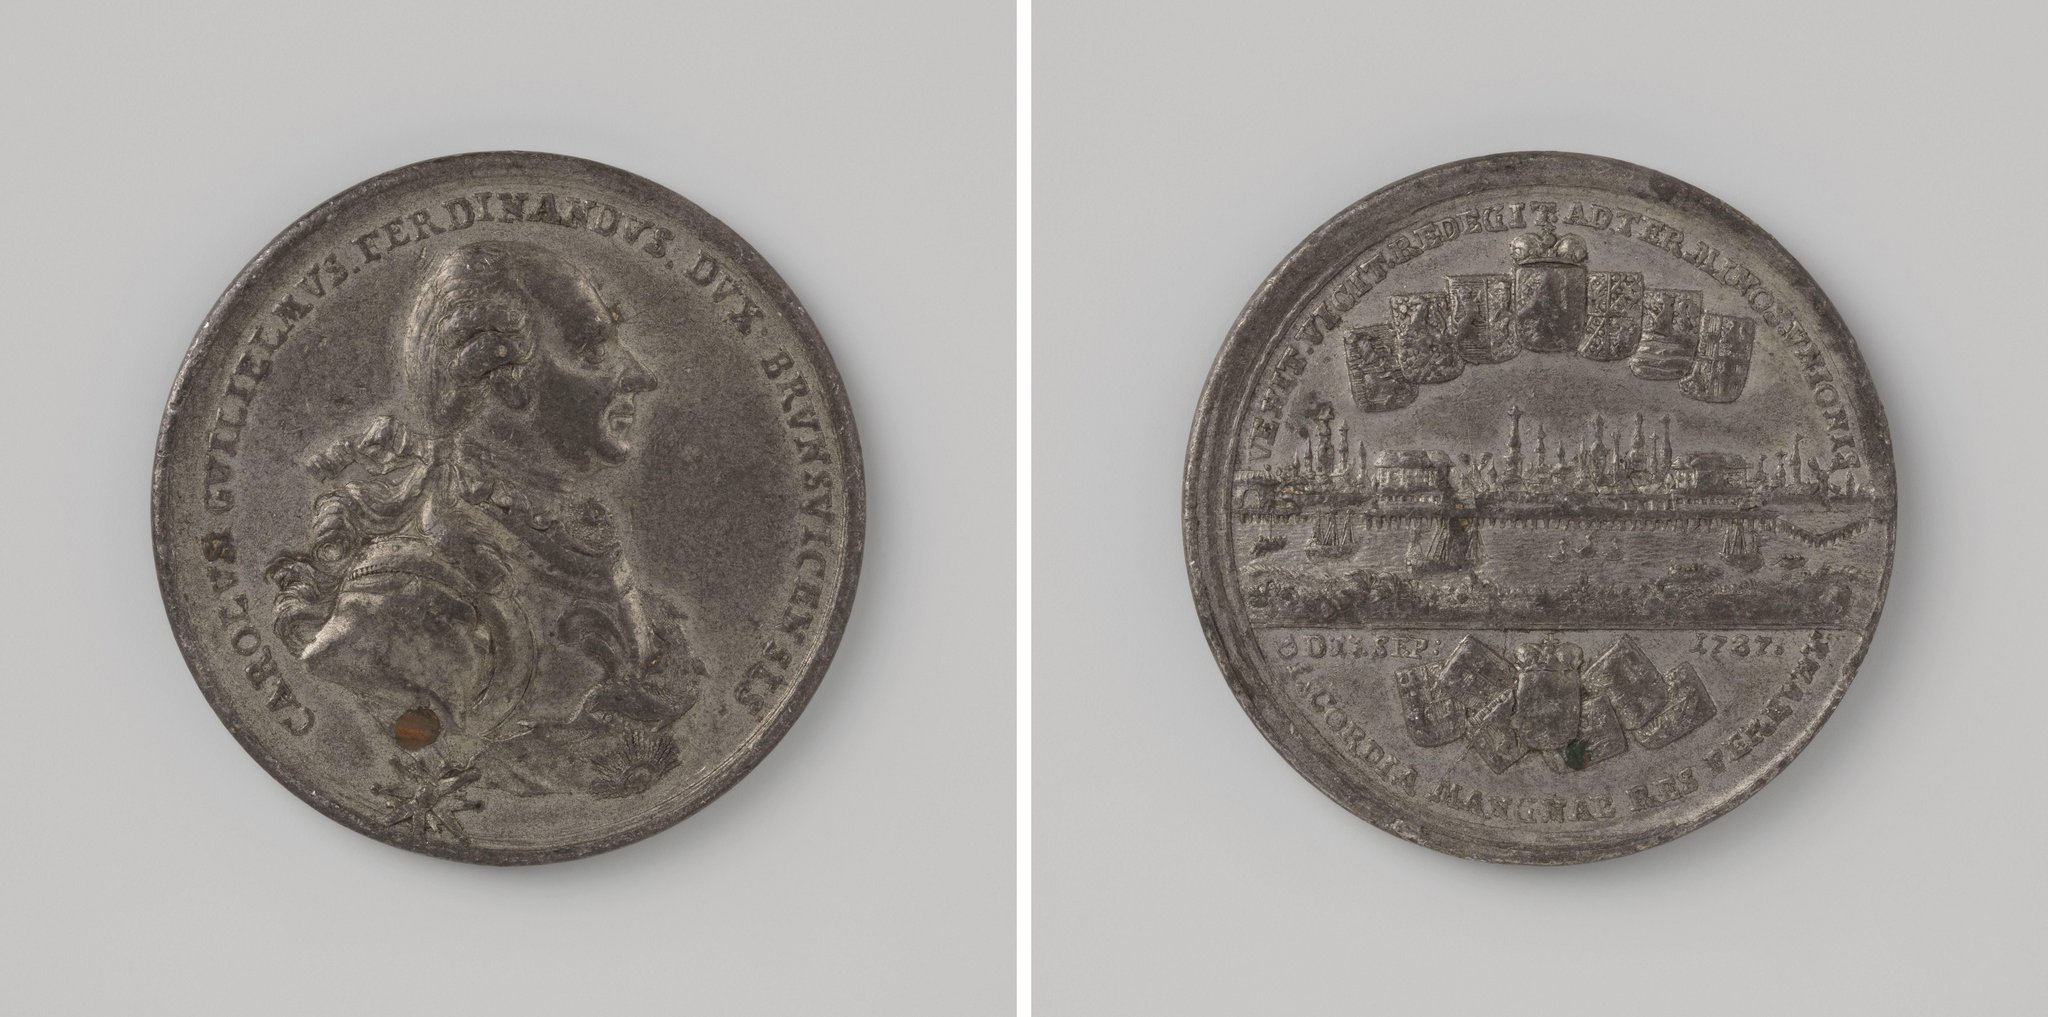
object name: history medal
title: Ordeherstel door de Hertog van Brunswijk 1787 ??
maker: johann christian reich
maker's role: medailleur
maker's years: 1740-1814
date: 1787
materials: copper, tin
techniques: striking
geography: furth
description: Tinnen penning met kleine koperen plug, op de voorzijde het borstbeeld van de Hertog naar rechts met omschrift, op de keerzijde het aanzicht van Amsterdam met de blokhuizen aan de Amstelzijde, met onder en boven de wapens der zeven provinciën, onderaan wanordelijk, bovenaan geordend, met omschrift en afsnedetekst.